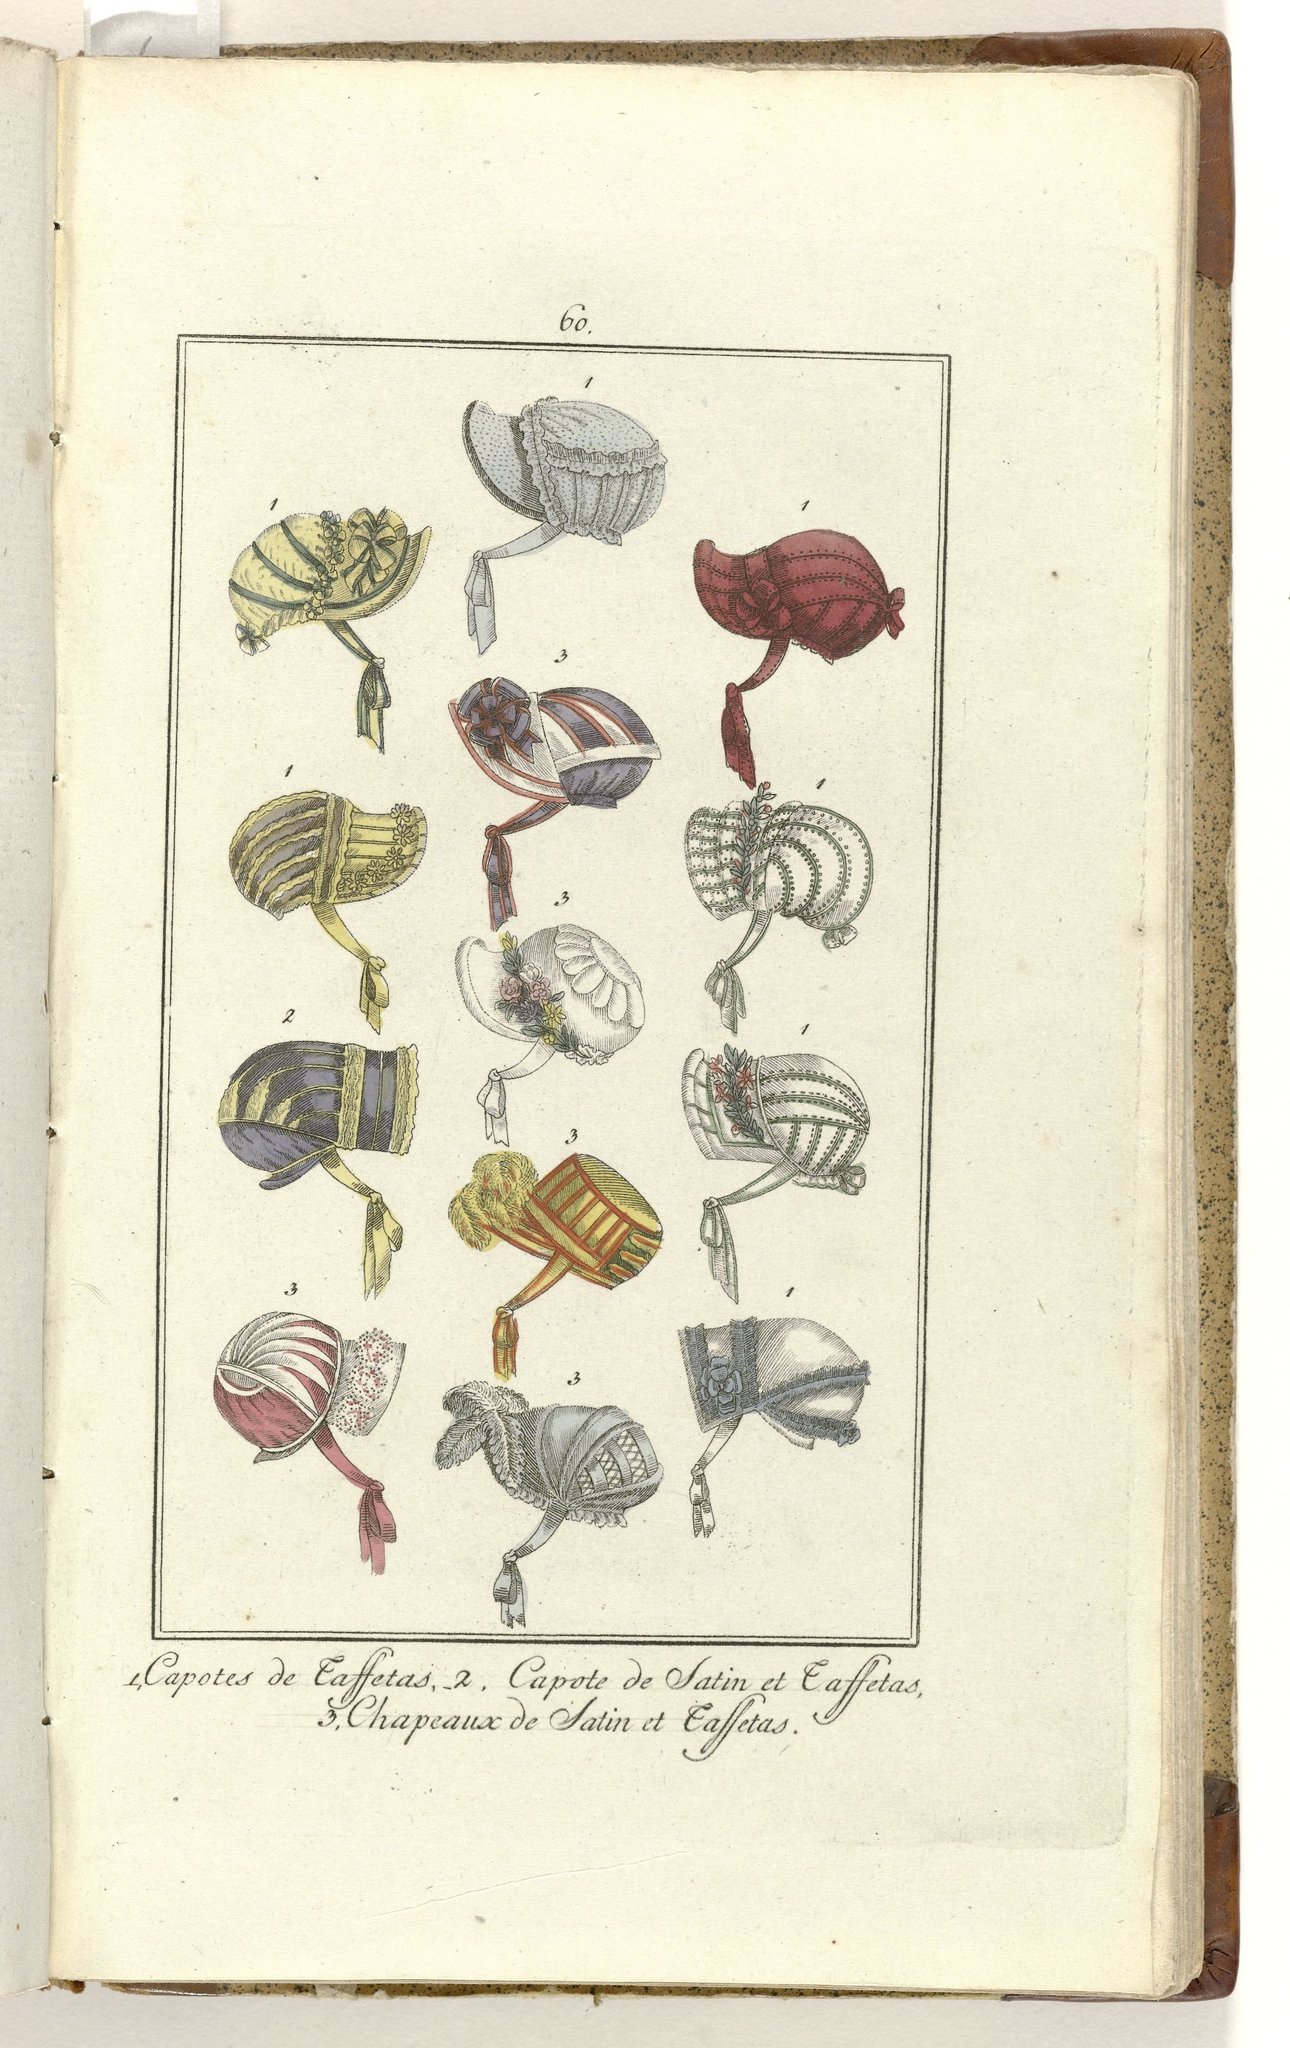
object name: magazine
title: Elegantia, of tijdschrift van mode, luxe en smaak voor dames, Oktober 1808, No. 60: 1. Capotes de Taffetas...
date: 1808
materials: paper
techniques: engraving, hand coloring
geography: amsterdam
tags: head-gear (capote) (+ women's clothes), fashion plates, head-gear: hat (+ women's clothes)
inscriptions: caption: ‘1. Capotes de Taffetas. 2. Capote de Satin et Taffetas. 3. Chapeaux de Satin et taffetas.’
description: Volgens de begeleidende tekst (p. 320): Dertien verschillende modellen van zijden hoeden en 'capotes' 'naar den nieuwsten smaak.' Volgens het onderschrift: 1. Capotes van tafzijde. 2. Capote van satijn en tafzijde. 3. Hoeden van satijn en tafzijde. Prent uit het modetijdschrift Elegantia, of tijdschrift van mode, luxe en smaak voor dames 1807-1814 (onderbroken door de periode 1811-1813).